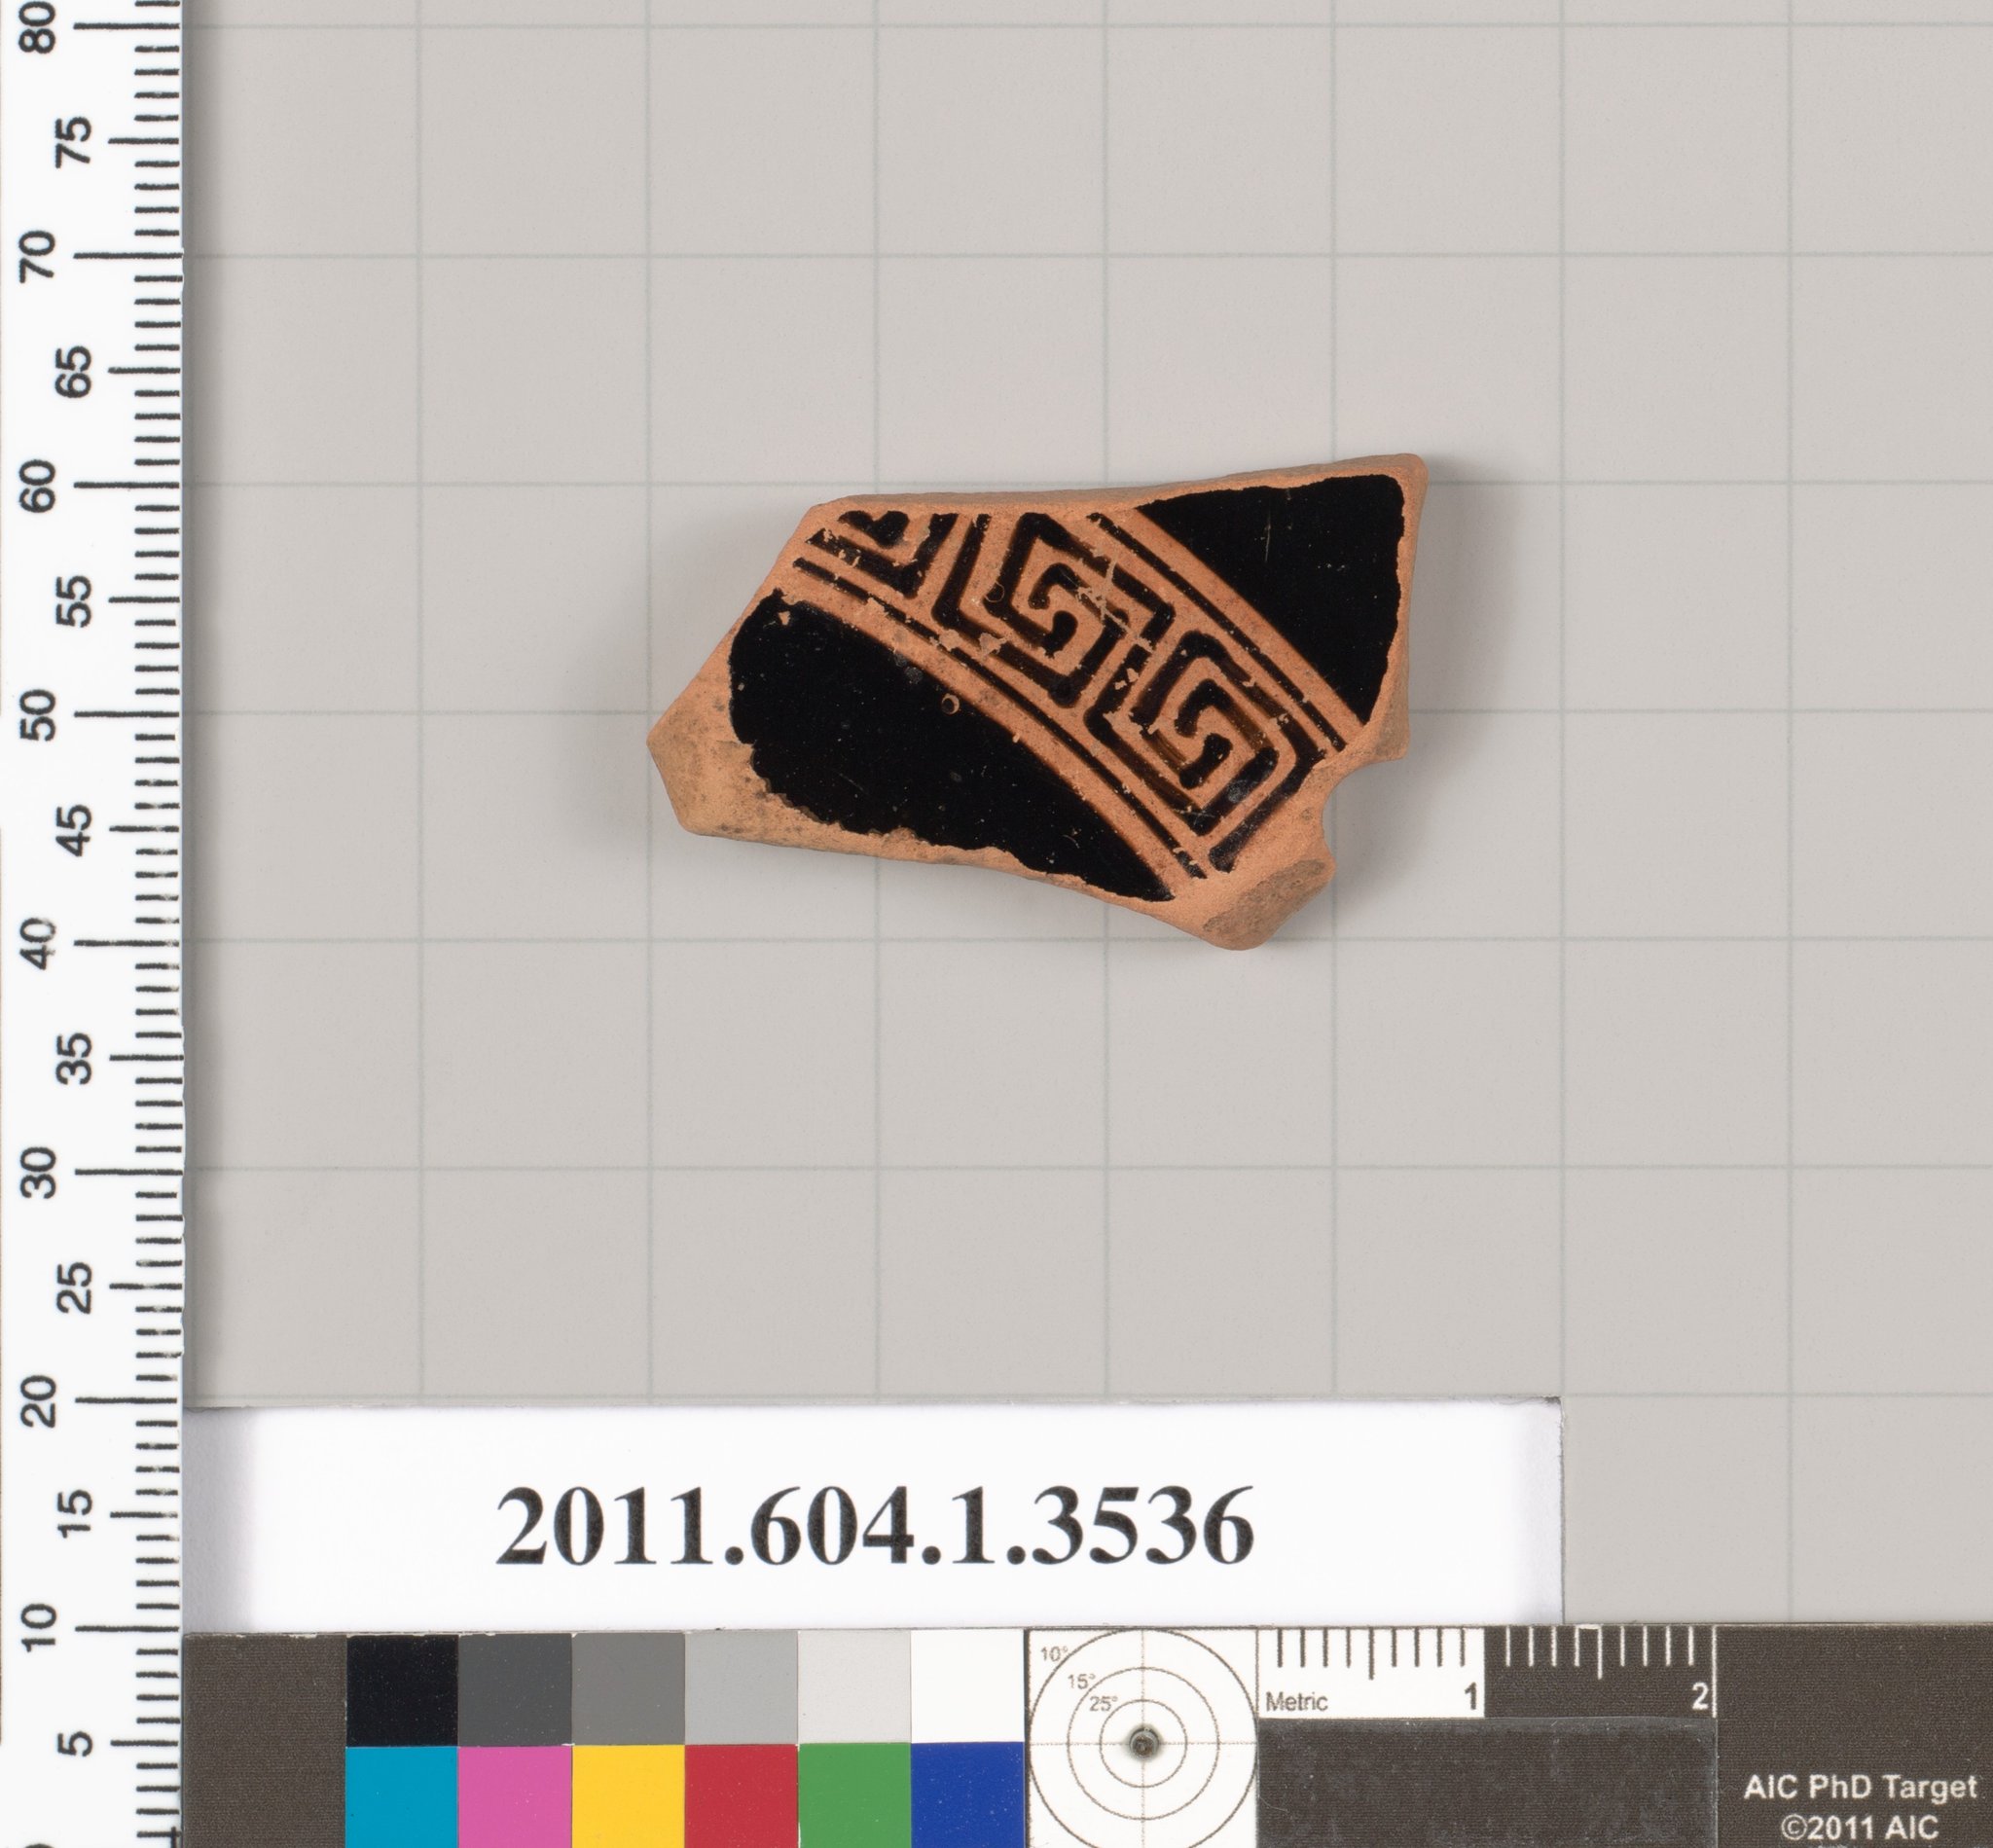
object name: kylix fragment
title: Terracotta fragment of a kylix (drinking cup)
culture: greek, attic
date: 500-490 BCE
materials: terracotta